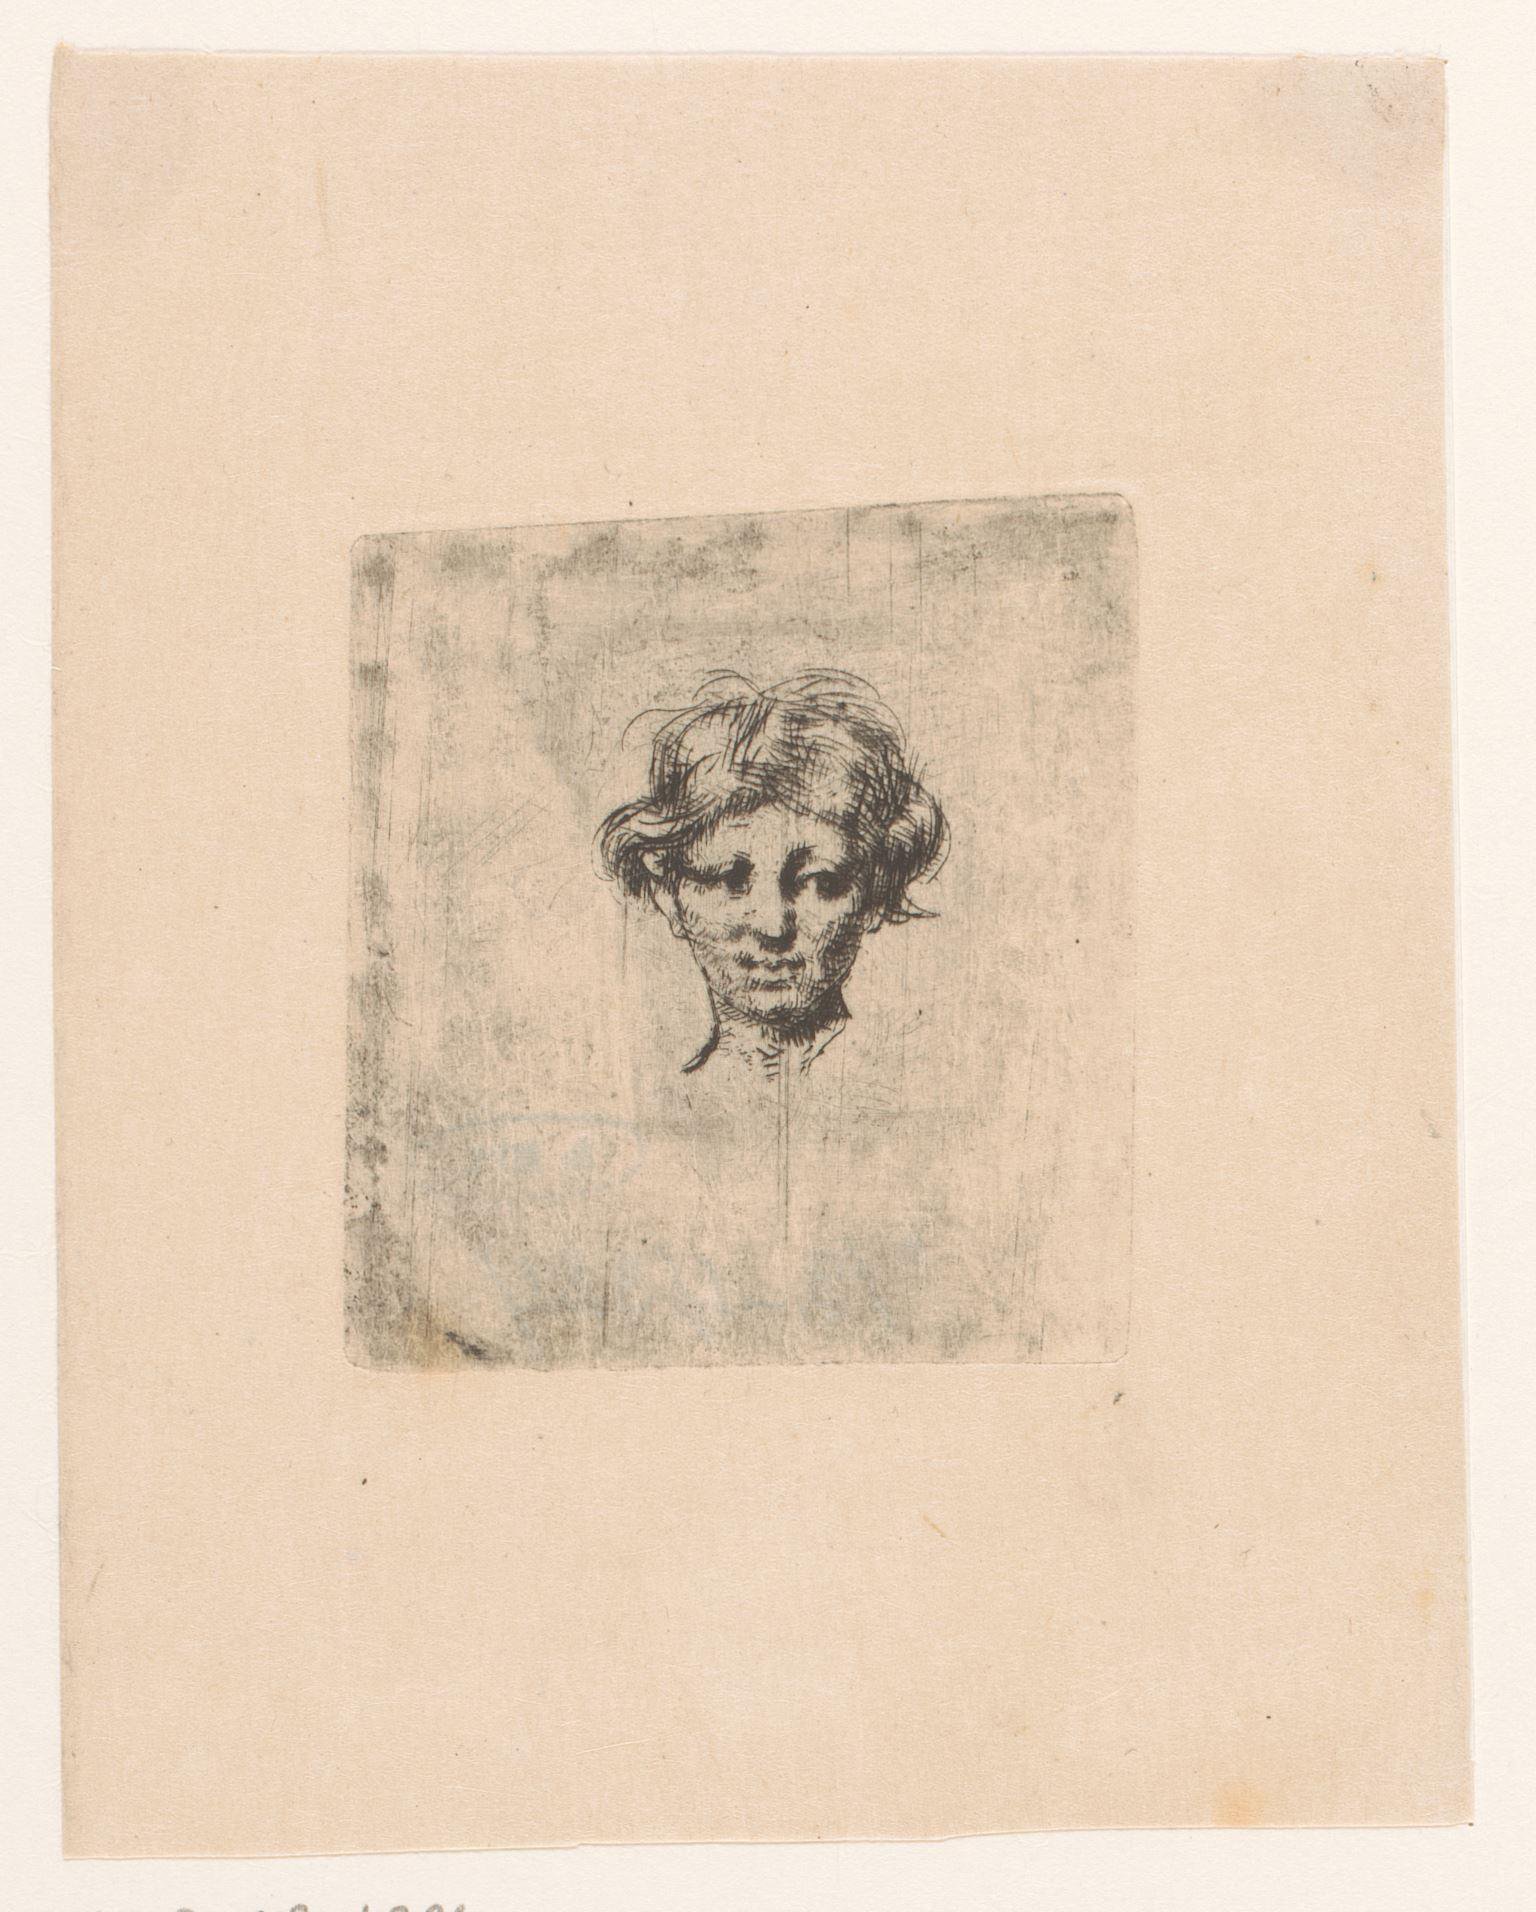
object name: print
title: Hoofd van een vrouw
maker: adrien de witte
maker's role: print maker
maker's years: 1850-1935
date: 1860-1913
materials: paper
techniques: drypoint, etching, intaglio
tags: adolescent, young woman, maiden, head (human) - aa - female human figure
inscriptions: collector's mark: Lugt 2228